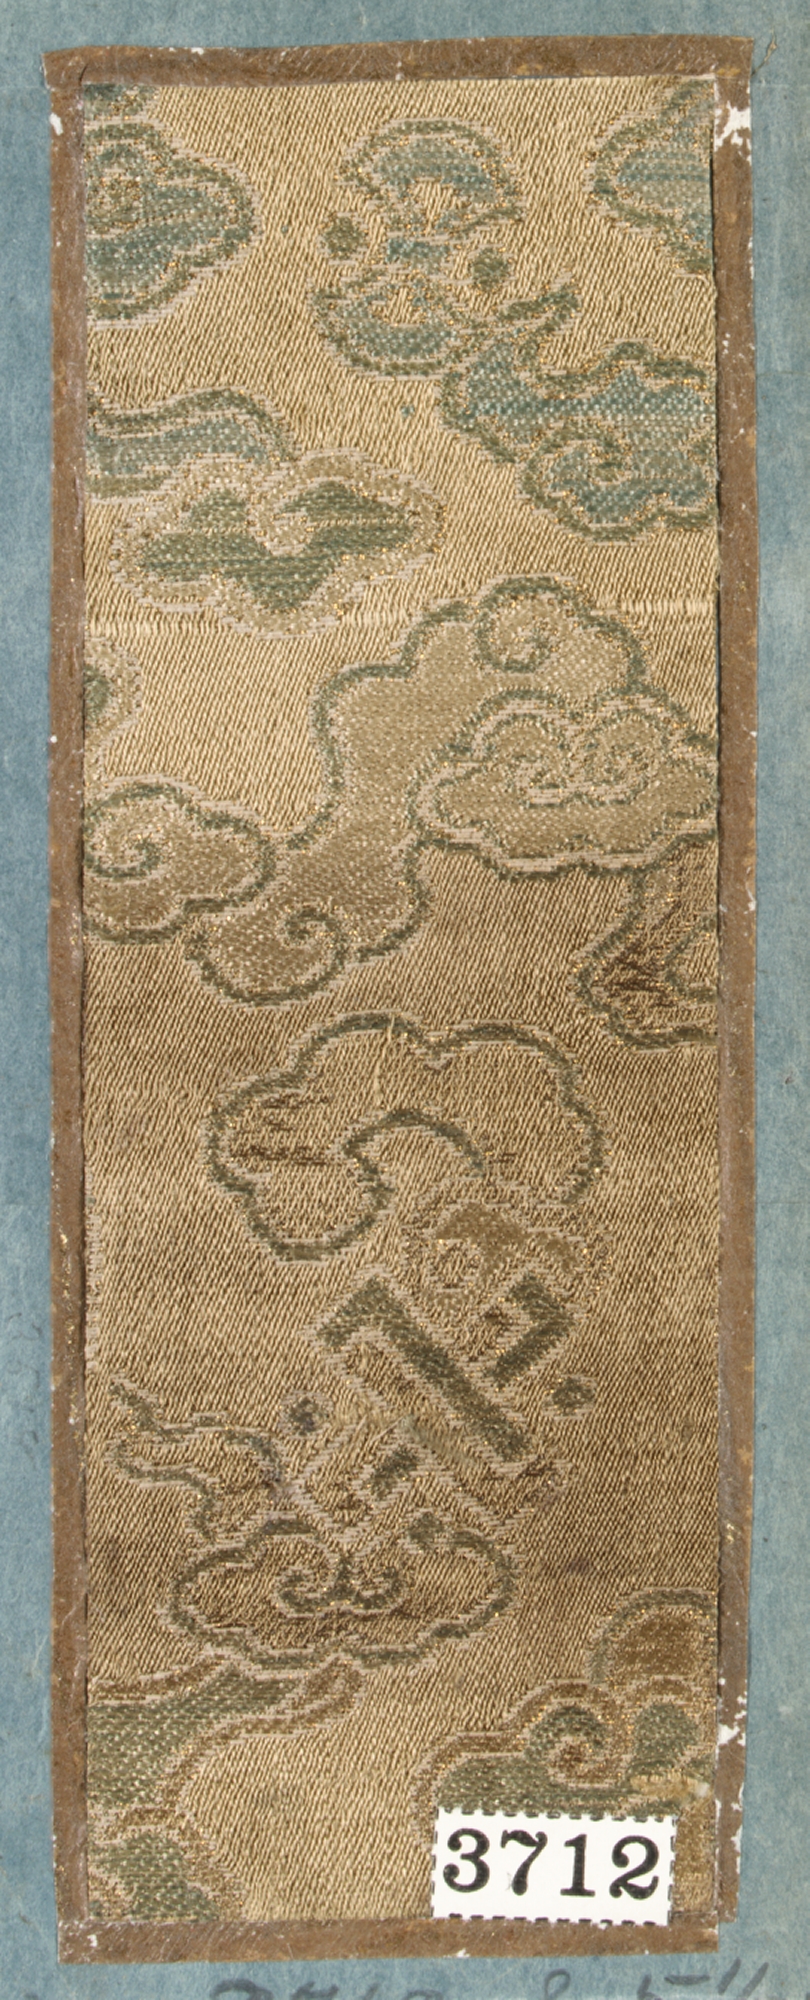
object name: sample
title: Textile Sample from Sample Book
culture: japanese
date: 1801-1900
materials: silk